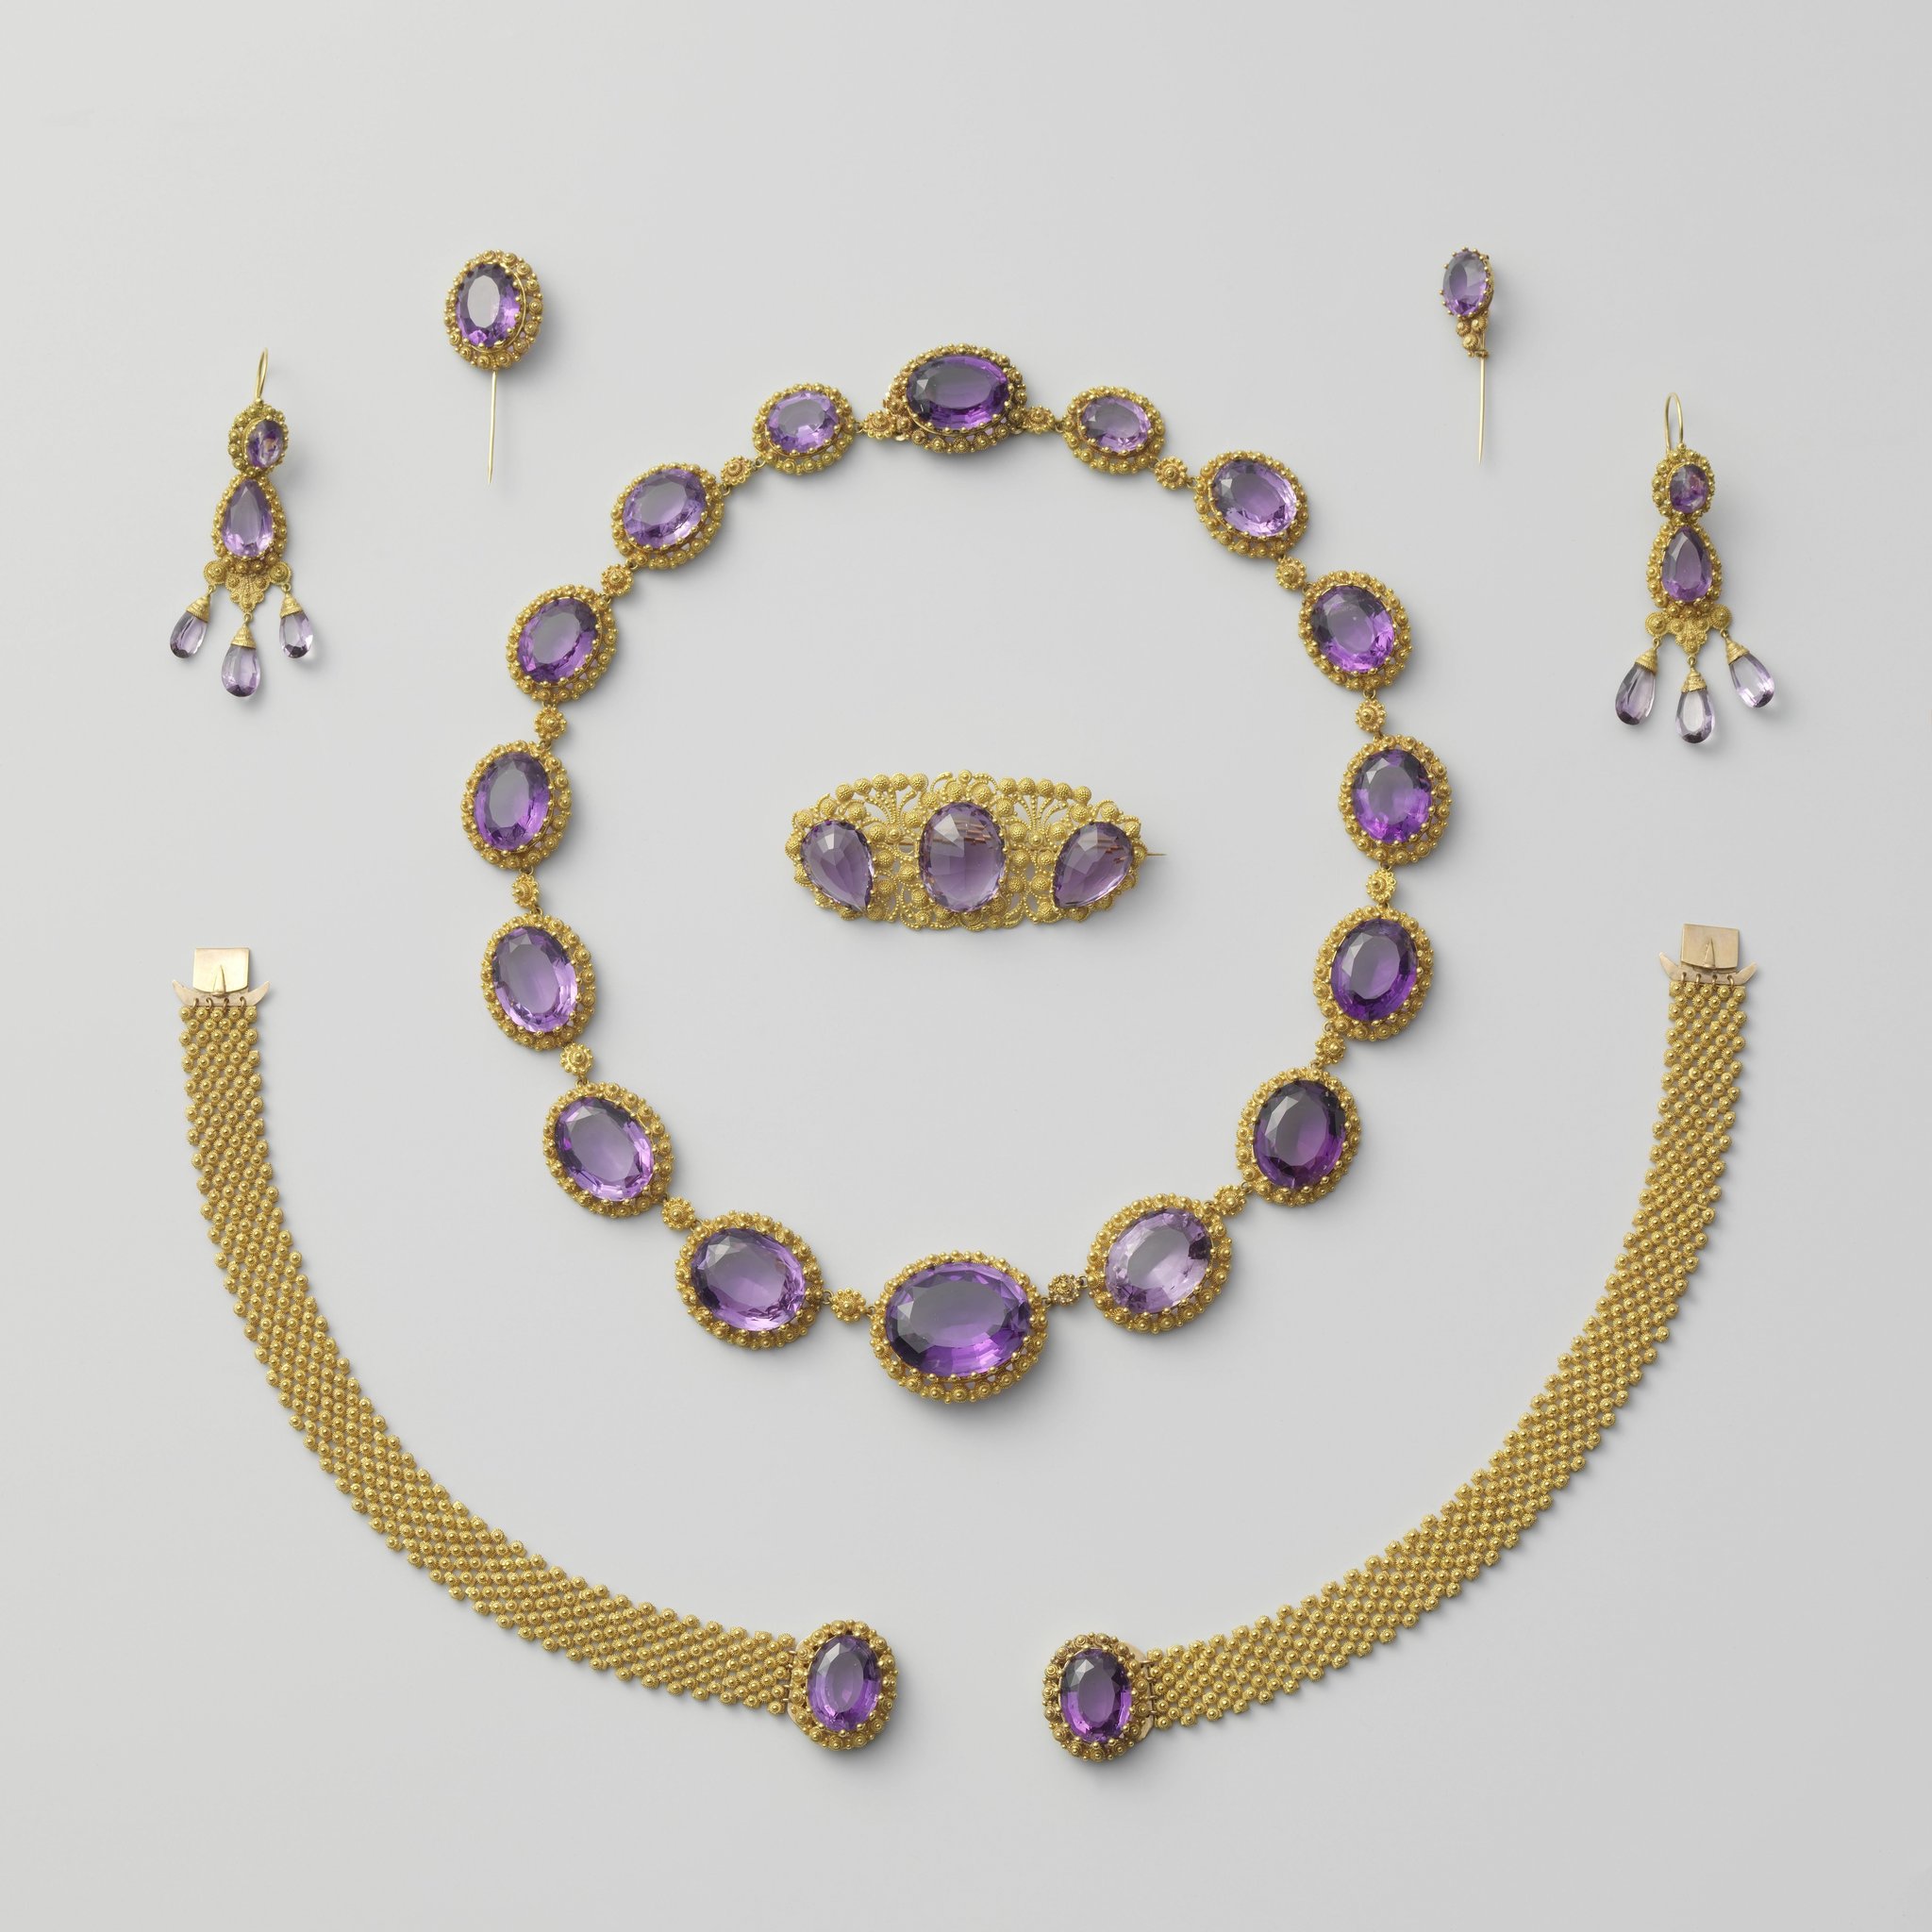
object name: parure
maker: jean baptiste bonnard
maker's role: goldsmith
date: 1824-1829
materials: gemstone, gold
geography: amsterdam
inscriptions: maker's mark: ‘BB met ster in ellips’, alloy mark: ‘leeuwenkop naar links (Nederland, 1813-1906)’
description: Parure. Gold and amethyst. Amsterdam, c. 1824 - 1829, by Jean Baptiste Bonnard.